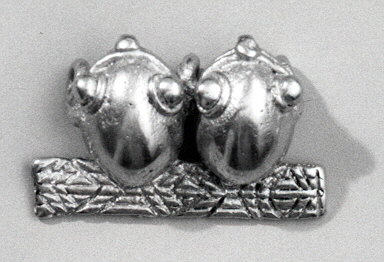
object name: ornament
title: Gold Double Frog Ornament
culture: veraguas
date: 1001-1600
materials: gold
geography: panama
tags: frogs